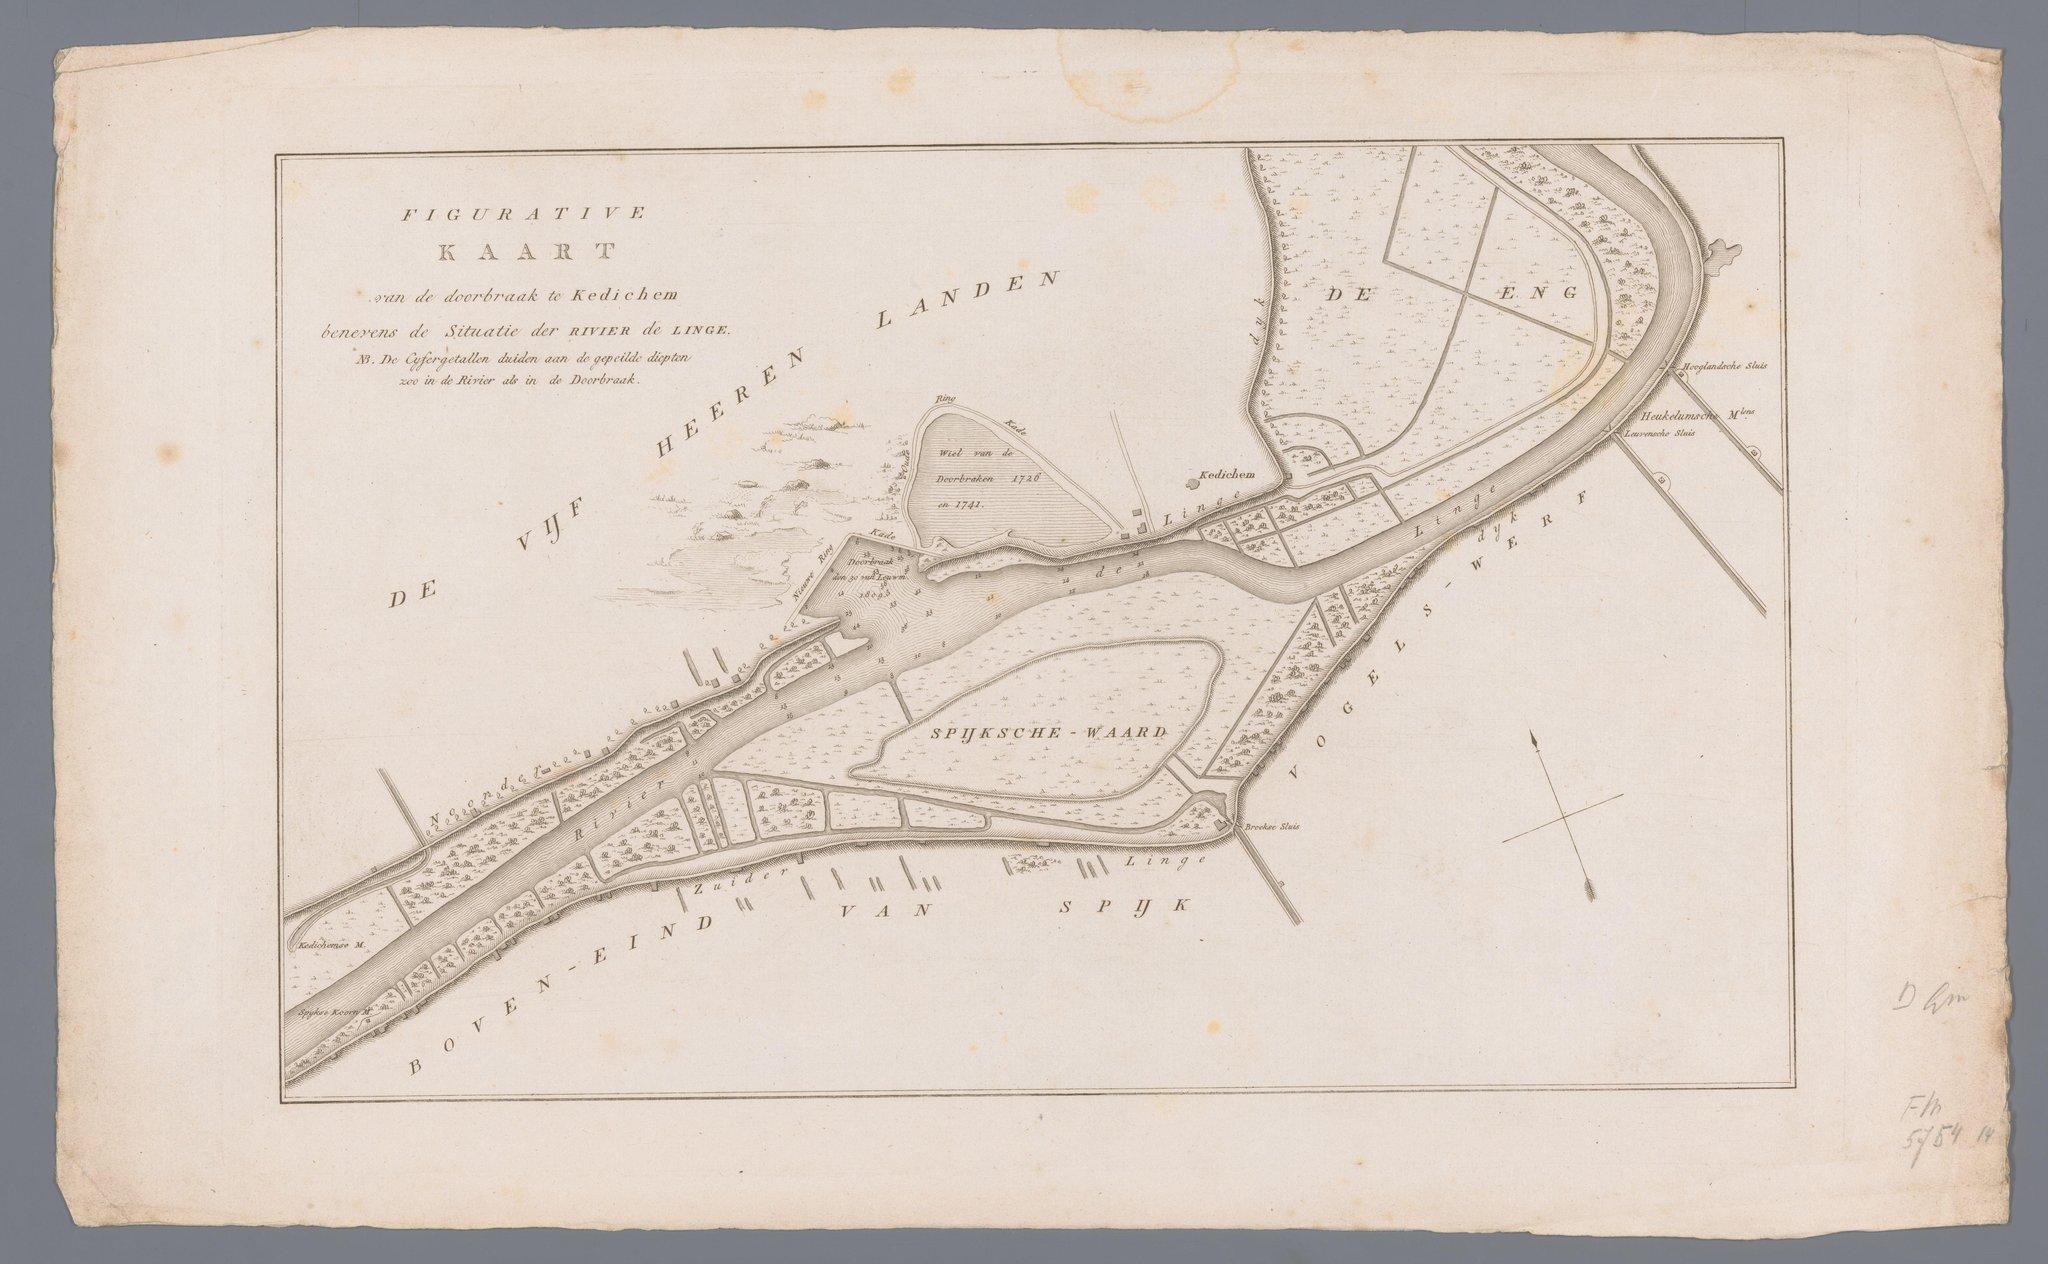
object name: book illustration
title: Figurative Kaart van de doorbraak te Kedichem benevens de Situatie der Rivier de Linge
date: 1809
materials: paper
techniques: etching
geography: netherlands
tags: dike-break, maps of separate countries or regions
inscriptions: collector's mark: Lugt 2228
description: Prent uit: Ewijk, Hendrik. Geschiedkundig verslag der dijkbreuken en overstroomingen, langs de rivieren in het Koningrijk Holland, voorgevallen in louwmaand MDCCCIX. Amsterdam: Johannes Allart en Jacobus Ruys, 1809.